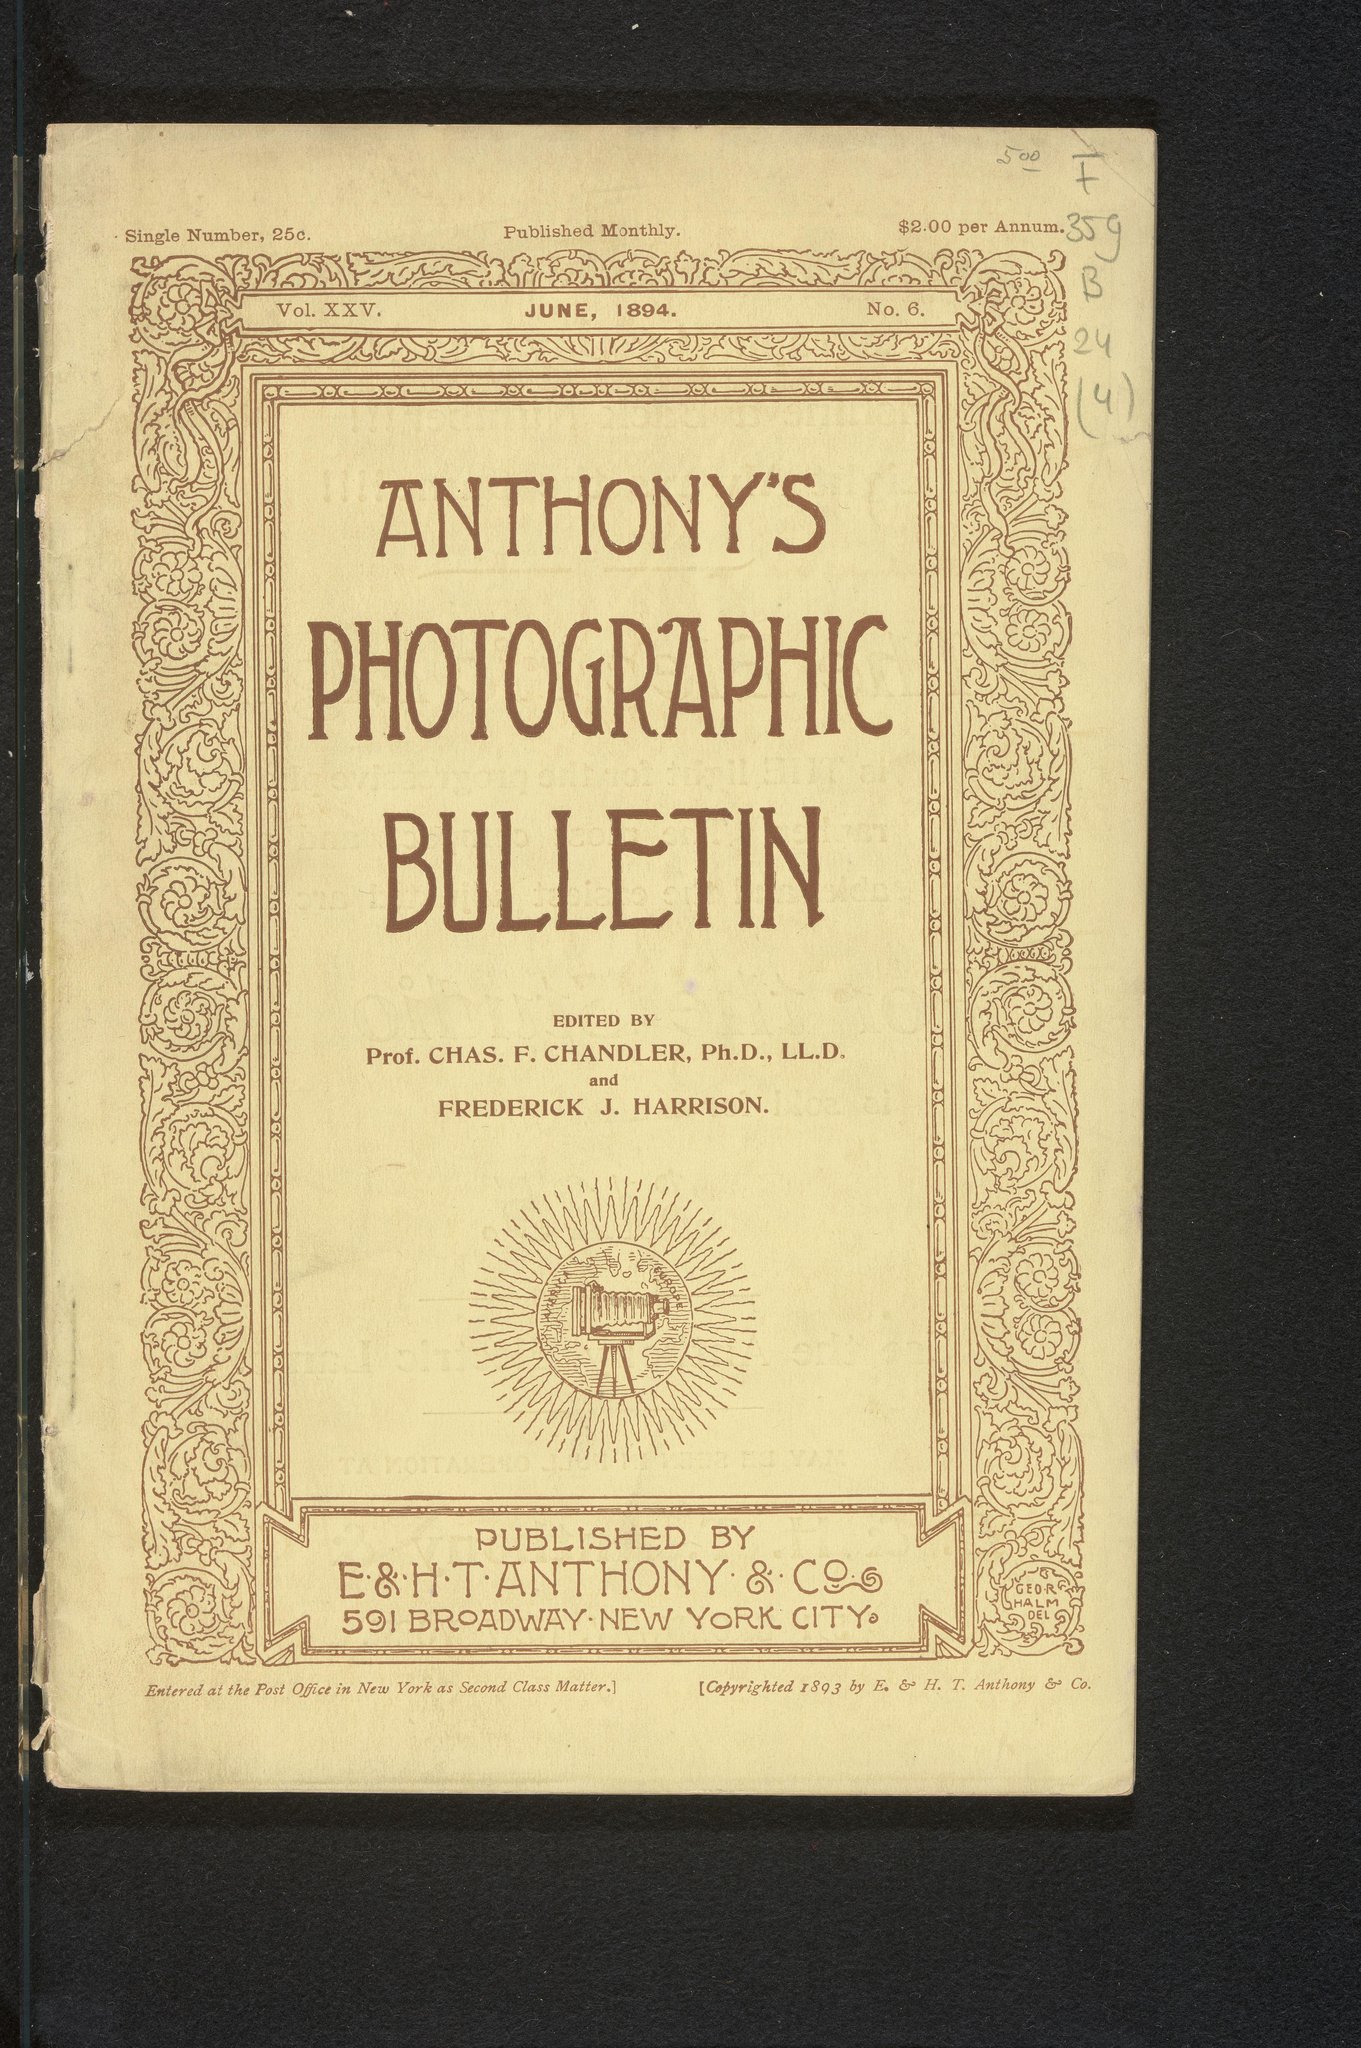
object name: book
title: Anthony's photographic bulletin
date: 1893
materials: paper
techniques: printing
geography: new york city